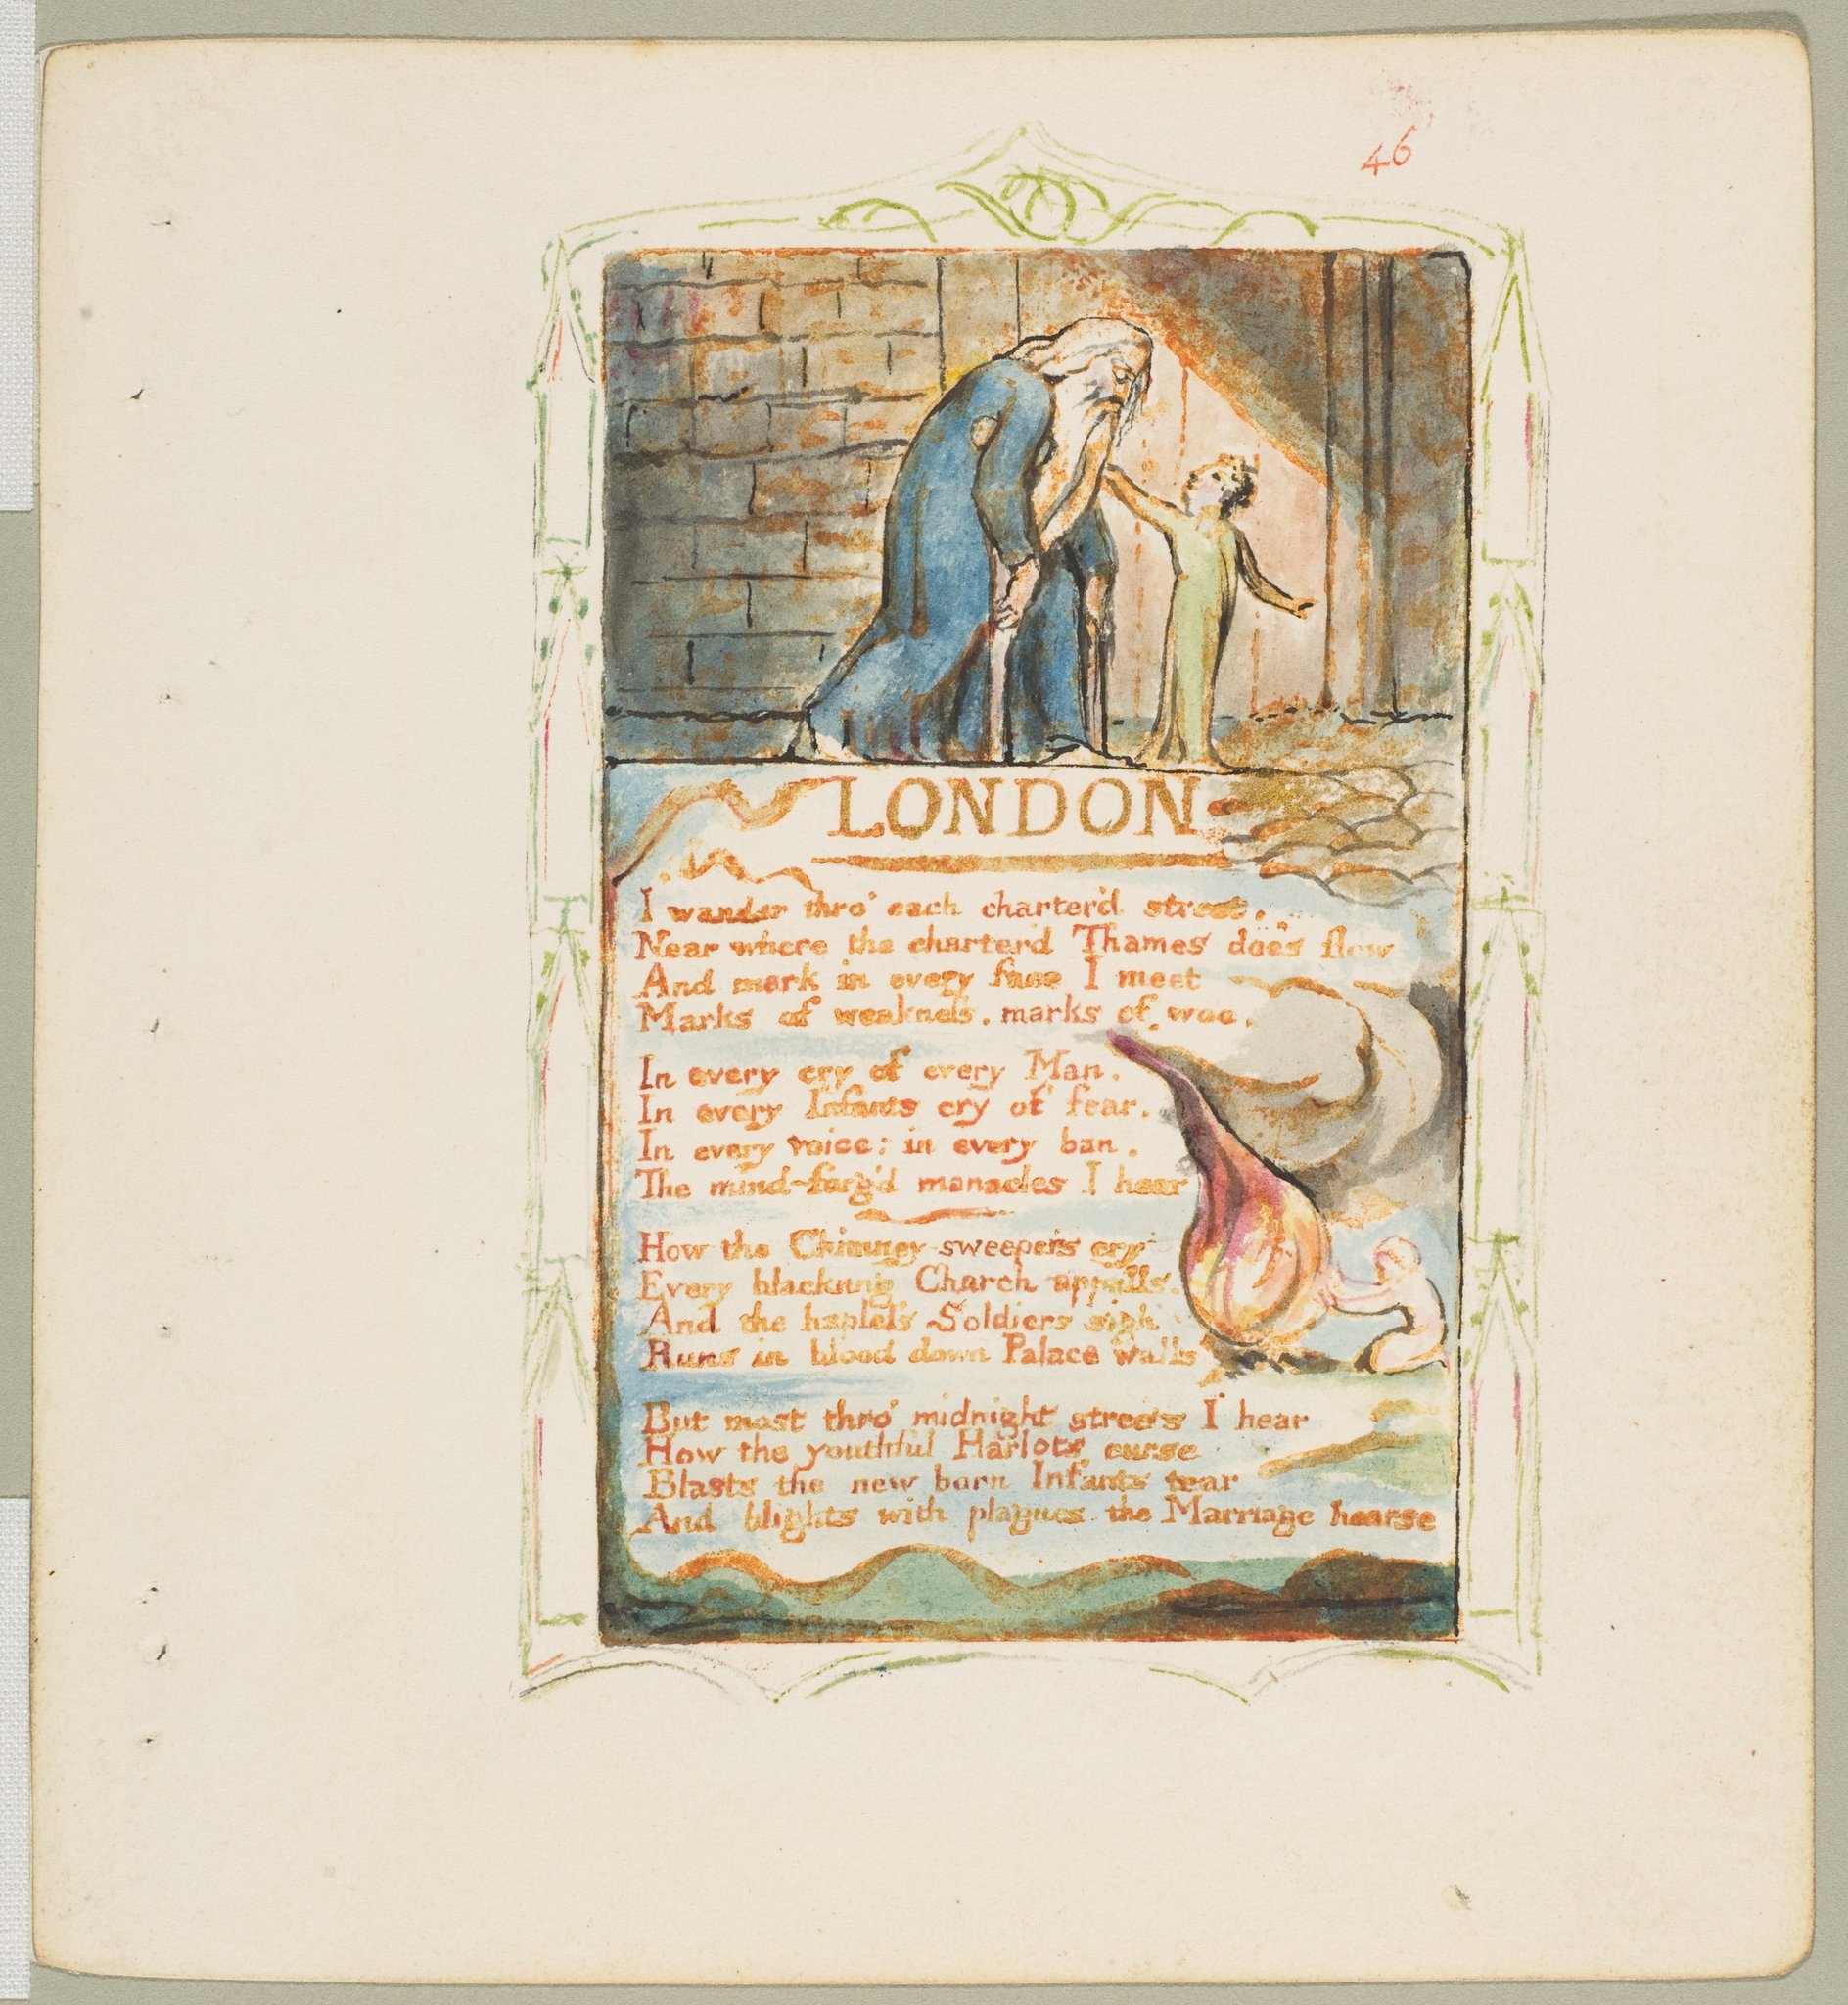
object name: print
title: Songs of Experience: London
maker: william blake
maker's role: artist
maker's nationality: british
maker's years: 1757-1827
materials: gold, ink, shell, watercolor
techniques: etching, hand coloring, printing, relief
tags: poetry,children,men